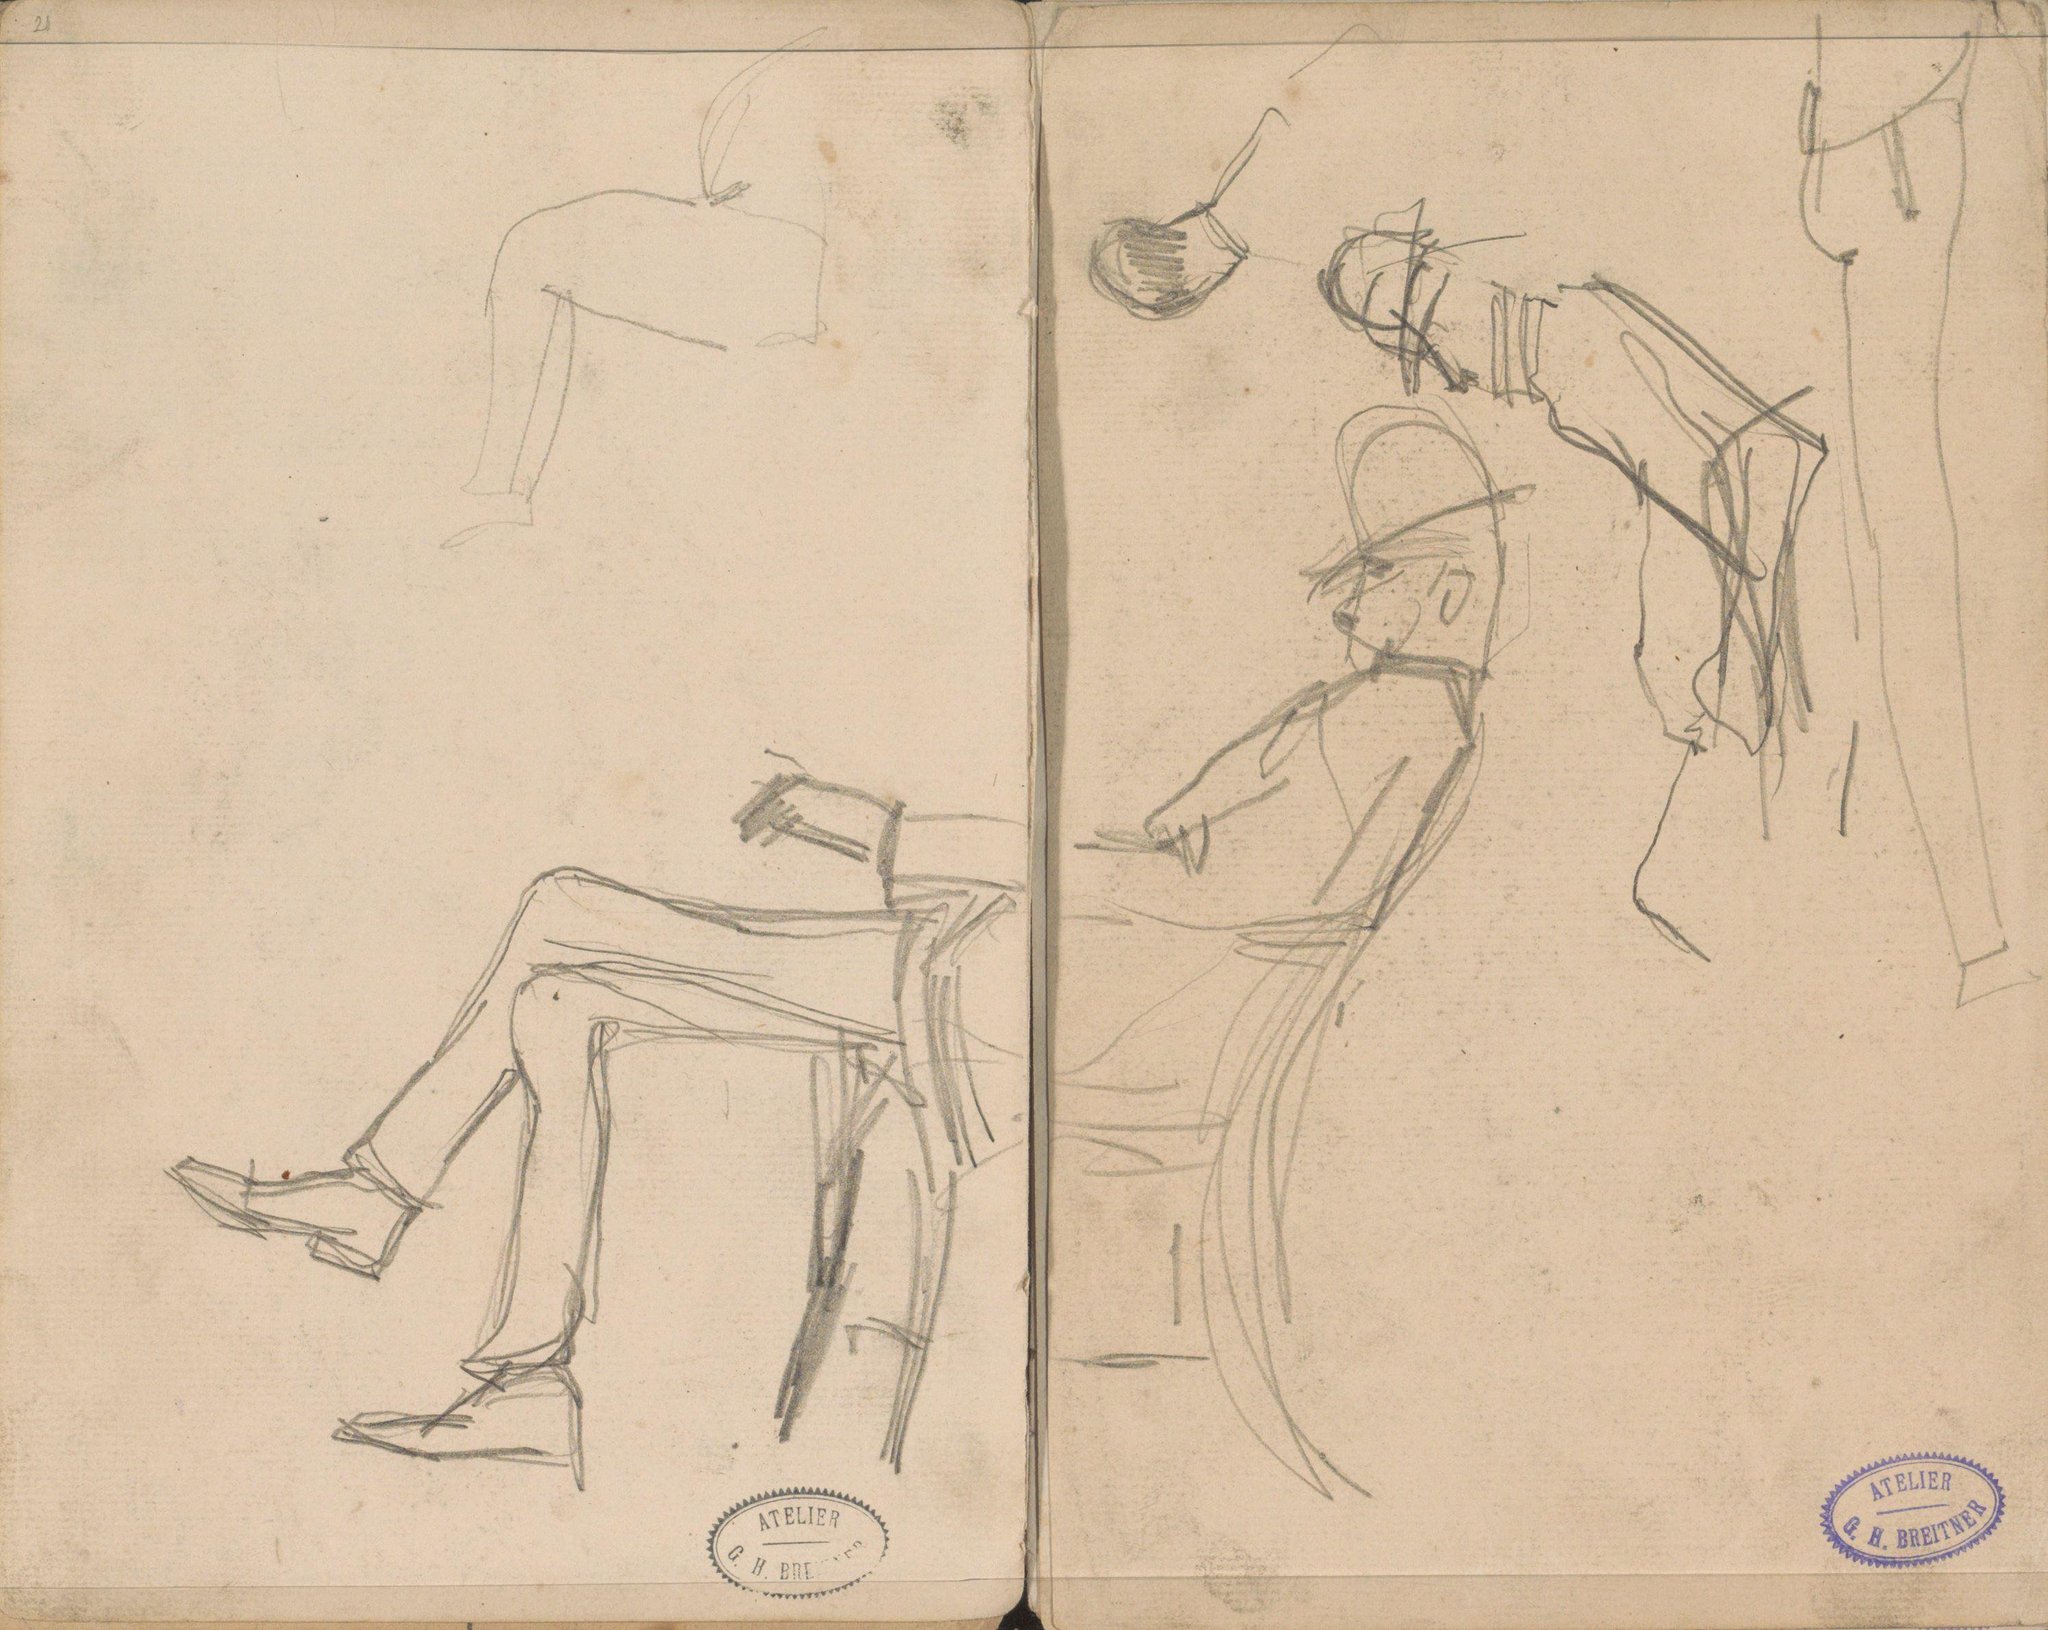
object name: sketchbook leaf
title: Studies van een man op een stoel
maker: george hendrik breitner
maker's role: draughtsman, painter, print maker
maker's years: 1857-1923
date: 1886-1923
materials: paper, pencil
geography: amsterdam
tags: adult man, chair, sitting on an elevation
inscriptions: workshop stamp: Lugt 291d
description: Pagina 21 en pagina 22 uit een schetsboek met 19 bladen en 9 losse tekeningen.